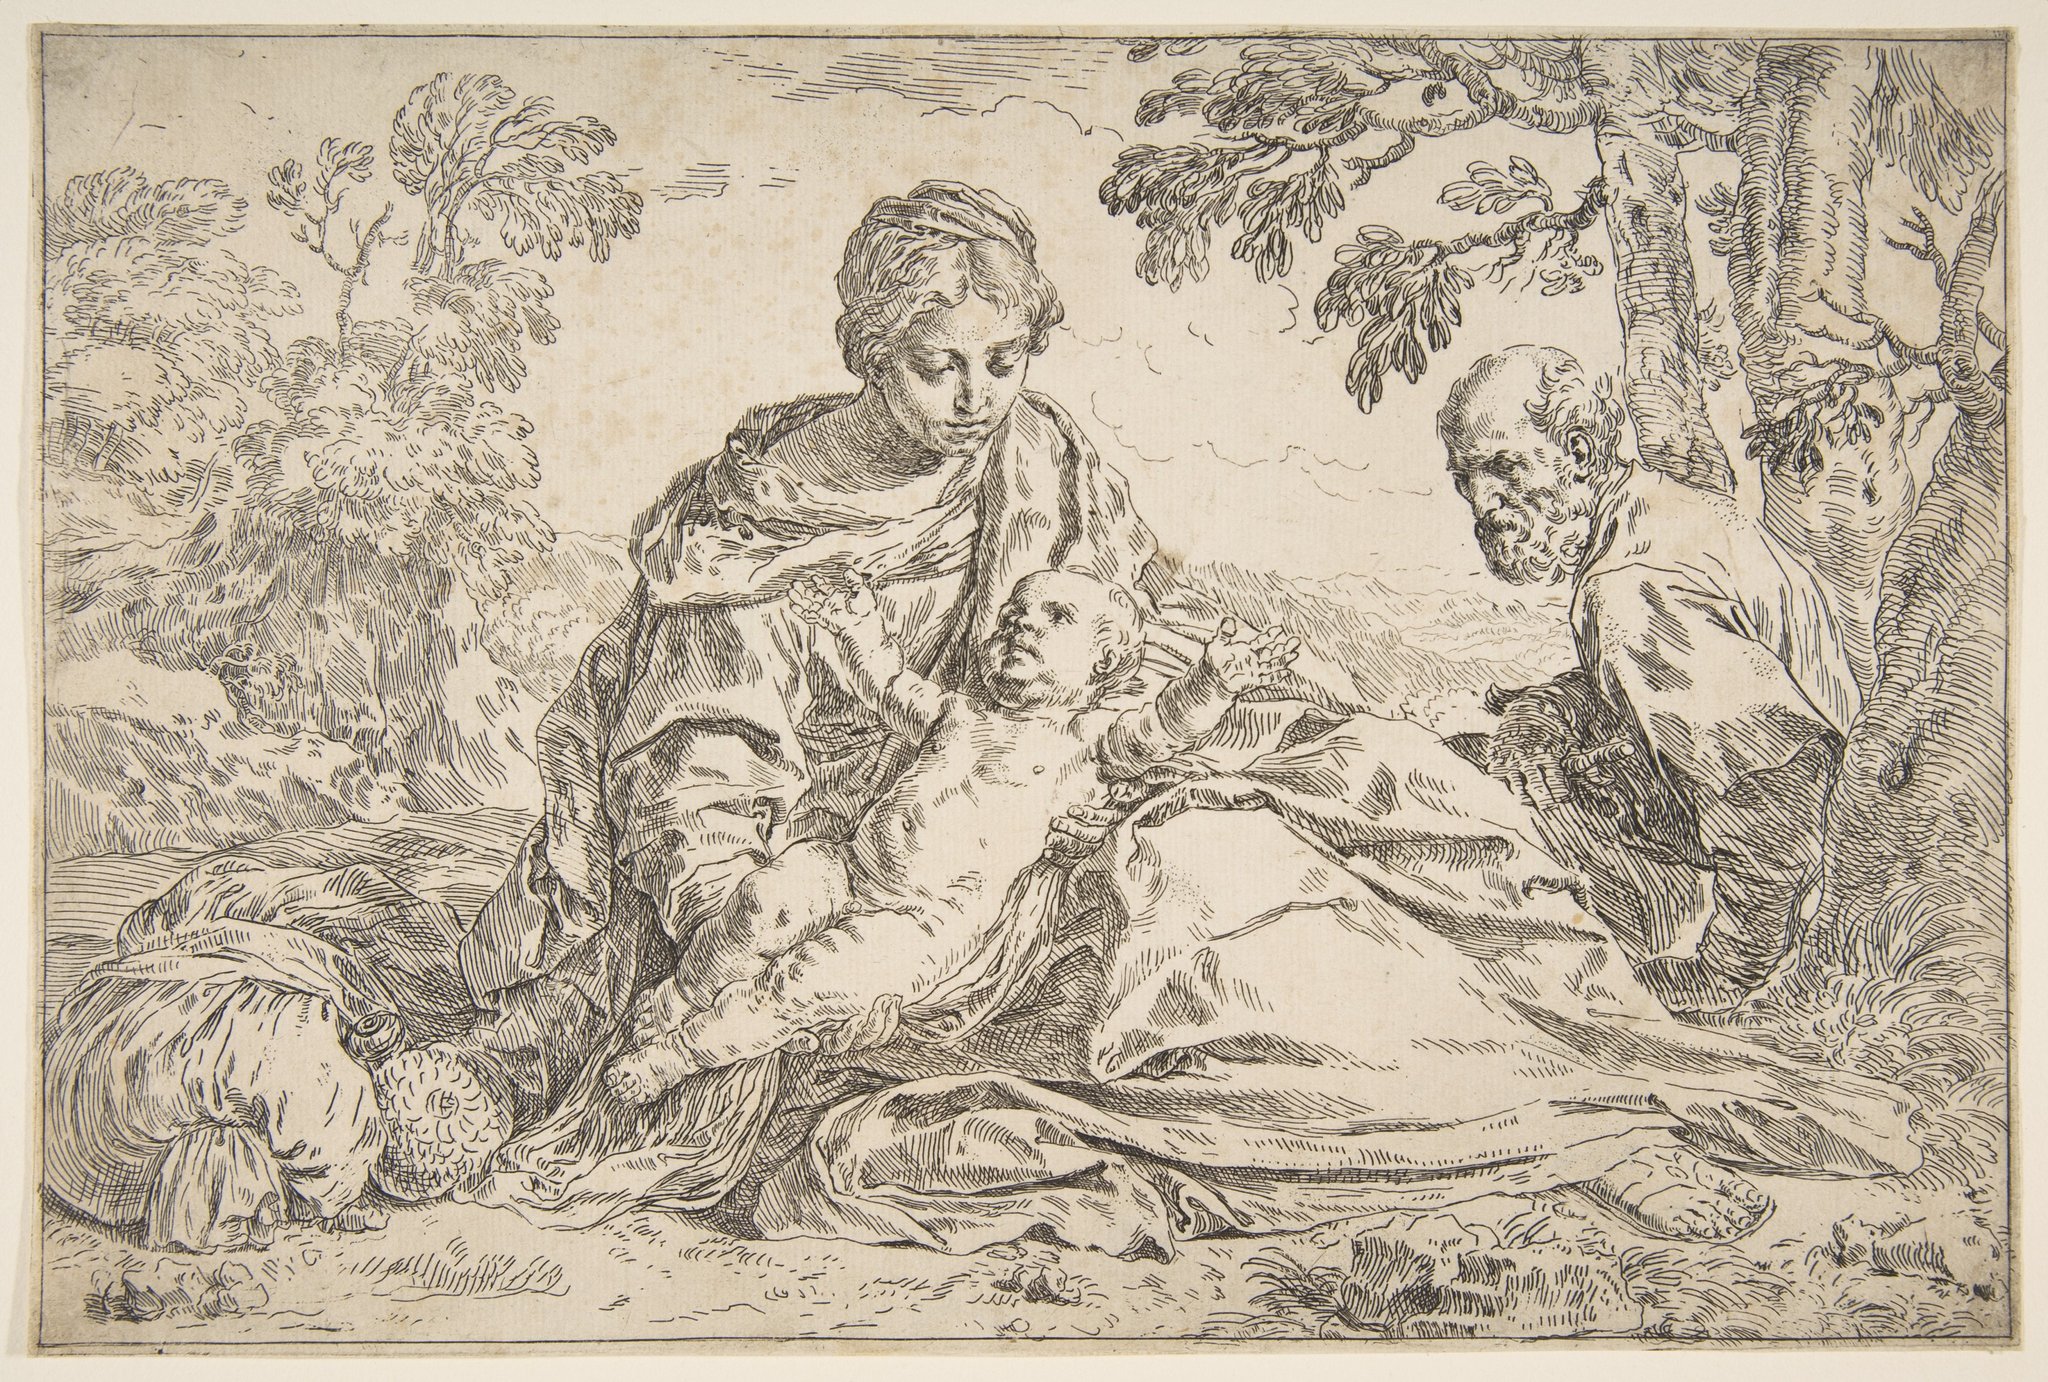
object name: print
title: Rest on the flight into Egypt, Mary holding the infant Christ with St. Joseph at right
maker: simone cantarini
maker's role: artist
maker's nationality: italian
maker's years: 1612-1648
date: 1640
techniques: etching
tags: christ,holy family,saint joseph,virgin mary